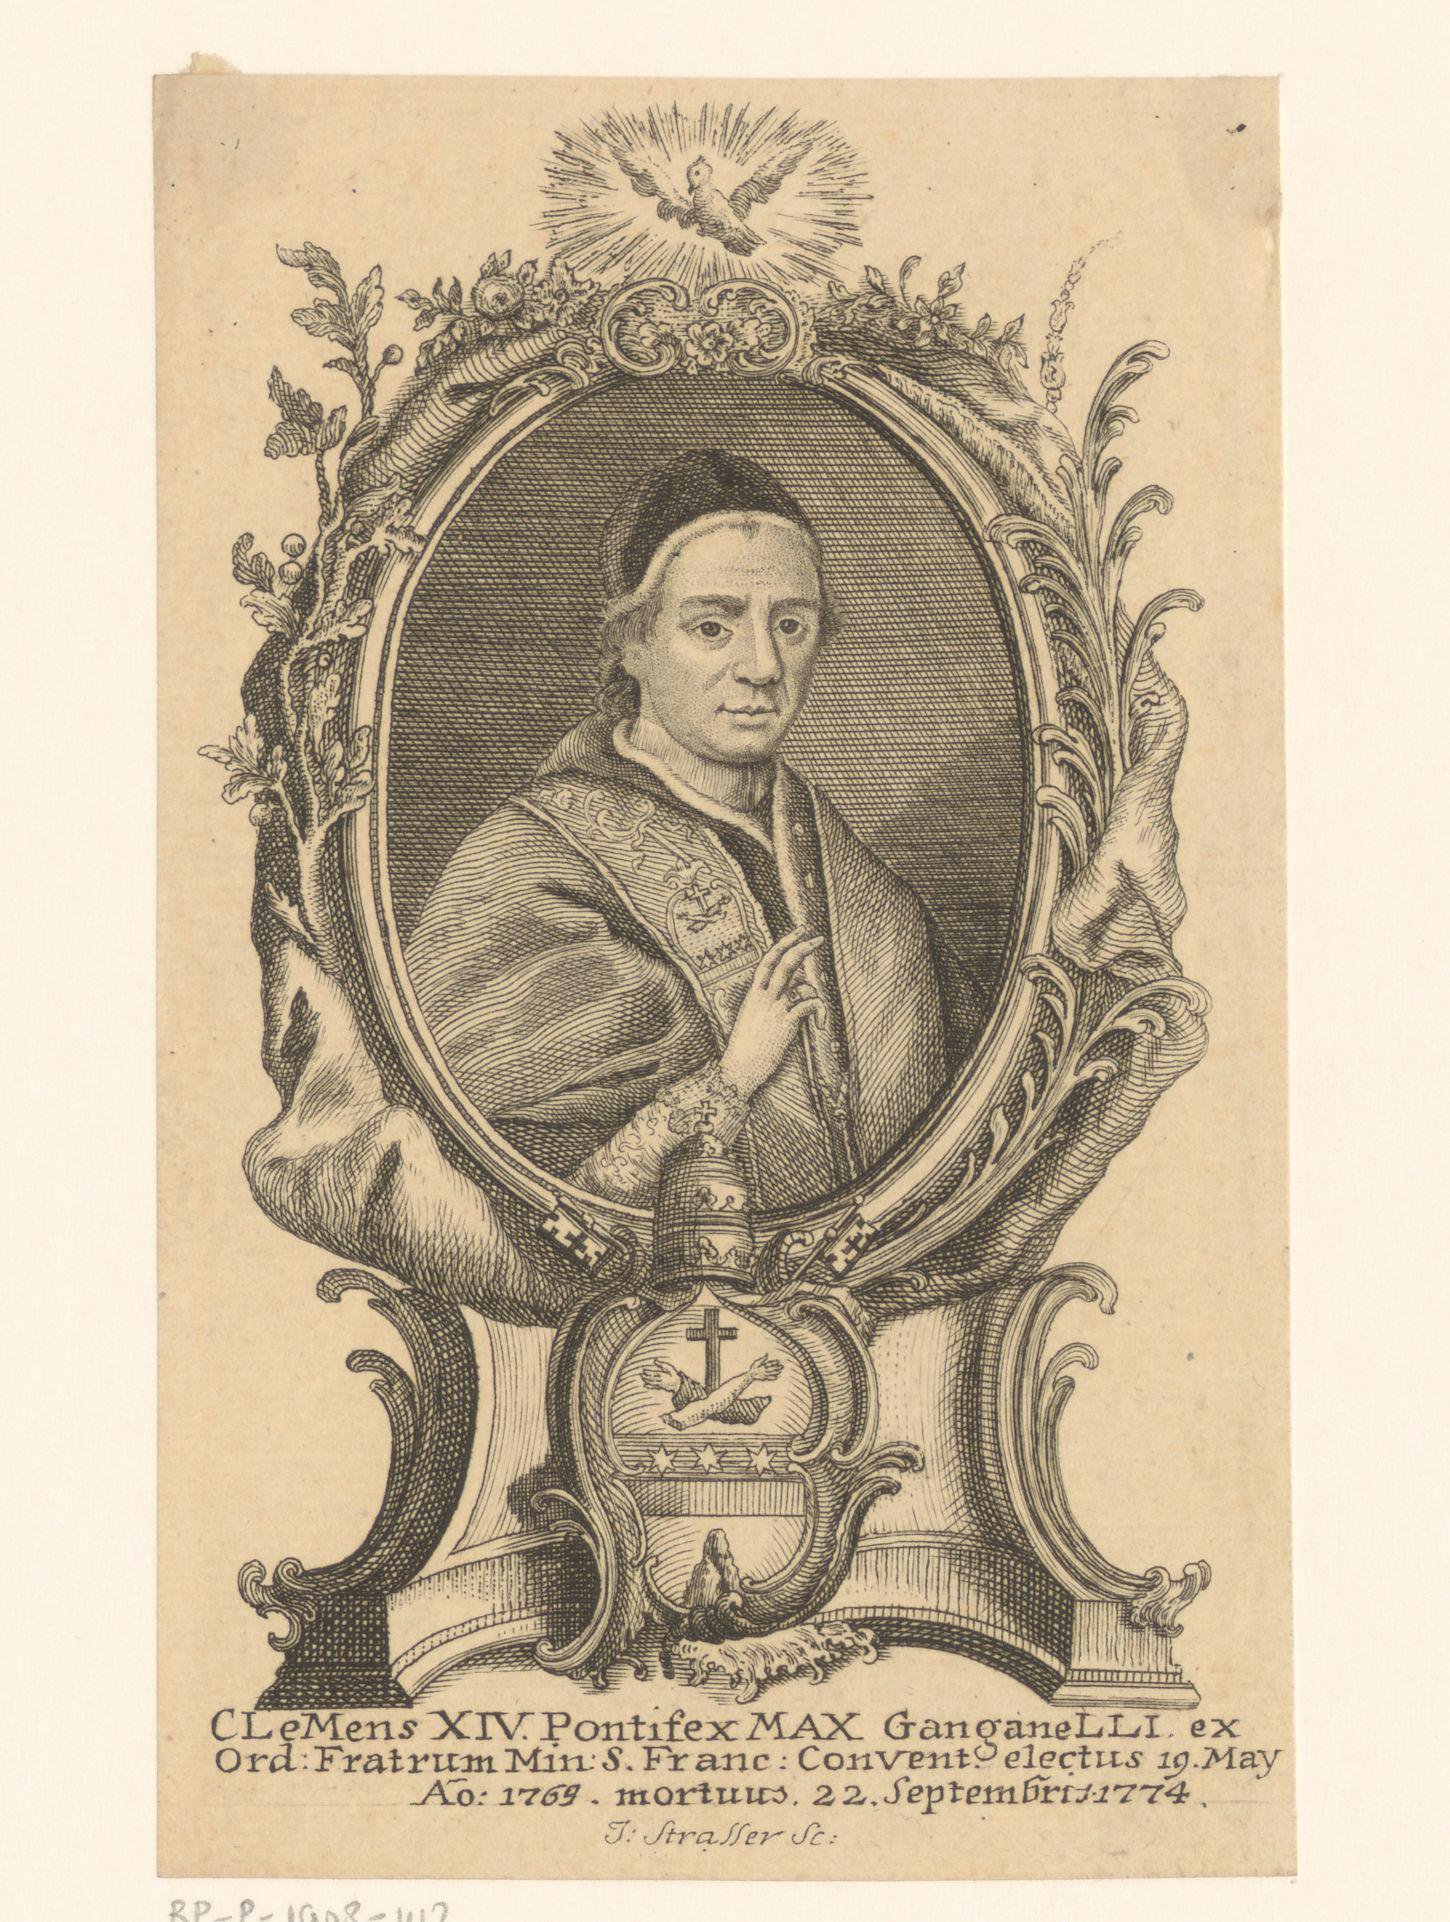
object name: print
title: Portret van paus Clemens XIV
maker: j. strasser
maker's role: print maker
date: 1774-1800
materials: paper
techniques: engraving, etching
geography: germany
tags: rome, historical persons, pope, armorial bearing, heraldry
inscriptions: collector's mark: Lugt 2228